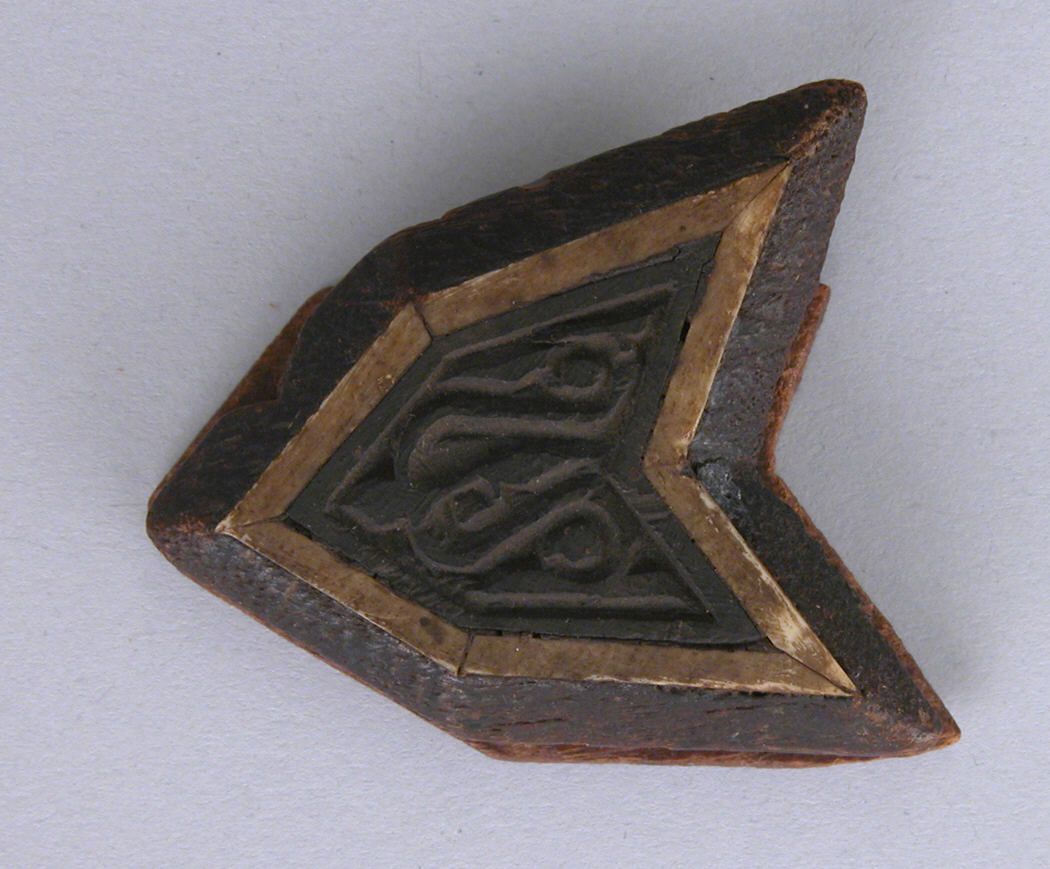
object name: panel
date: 1301-1500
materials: ivory, wood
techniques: carving, inlay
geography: egypt